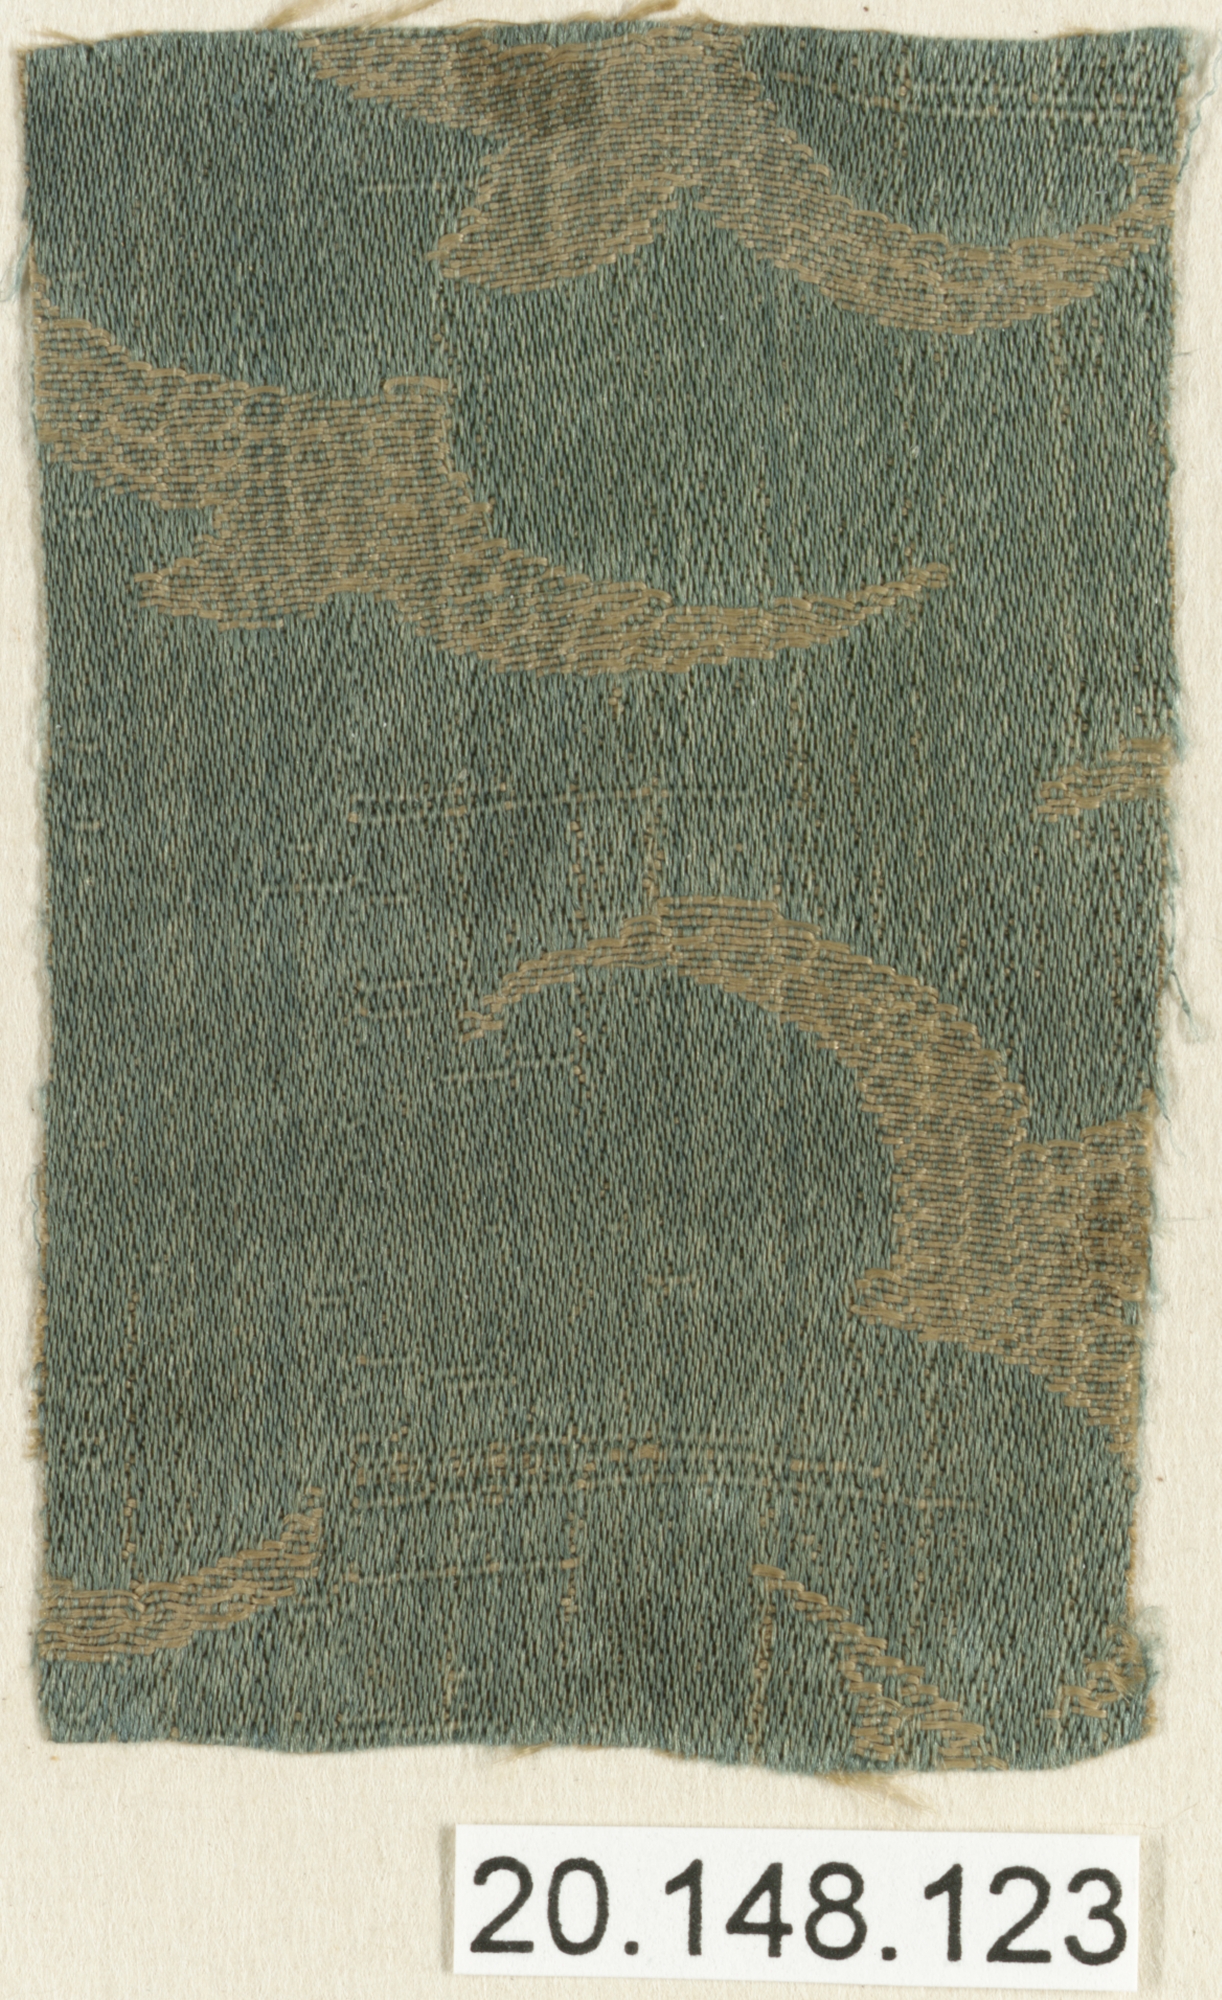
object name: piece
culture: japanese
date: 1601-1700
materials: silk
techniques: compound weave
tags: birds